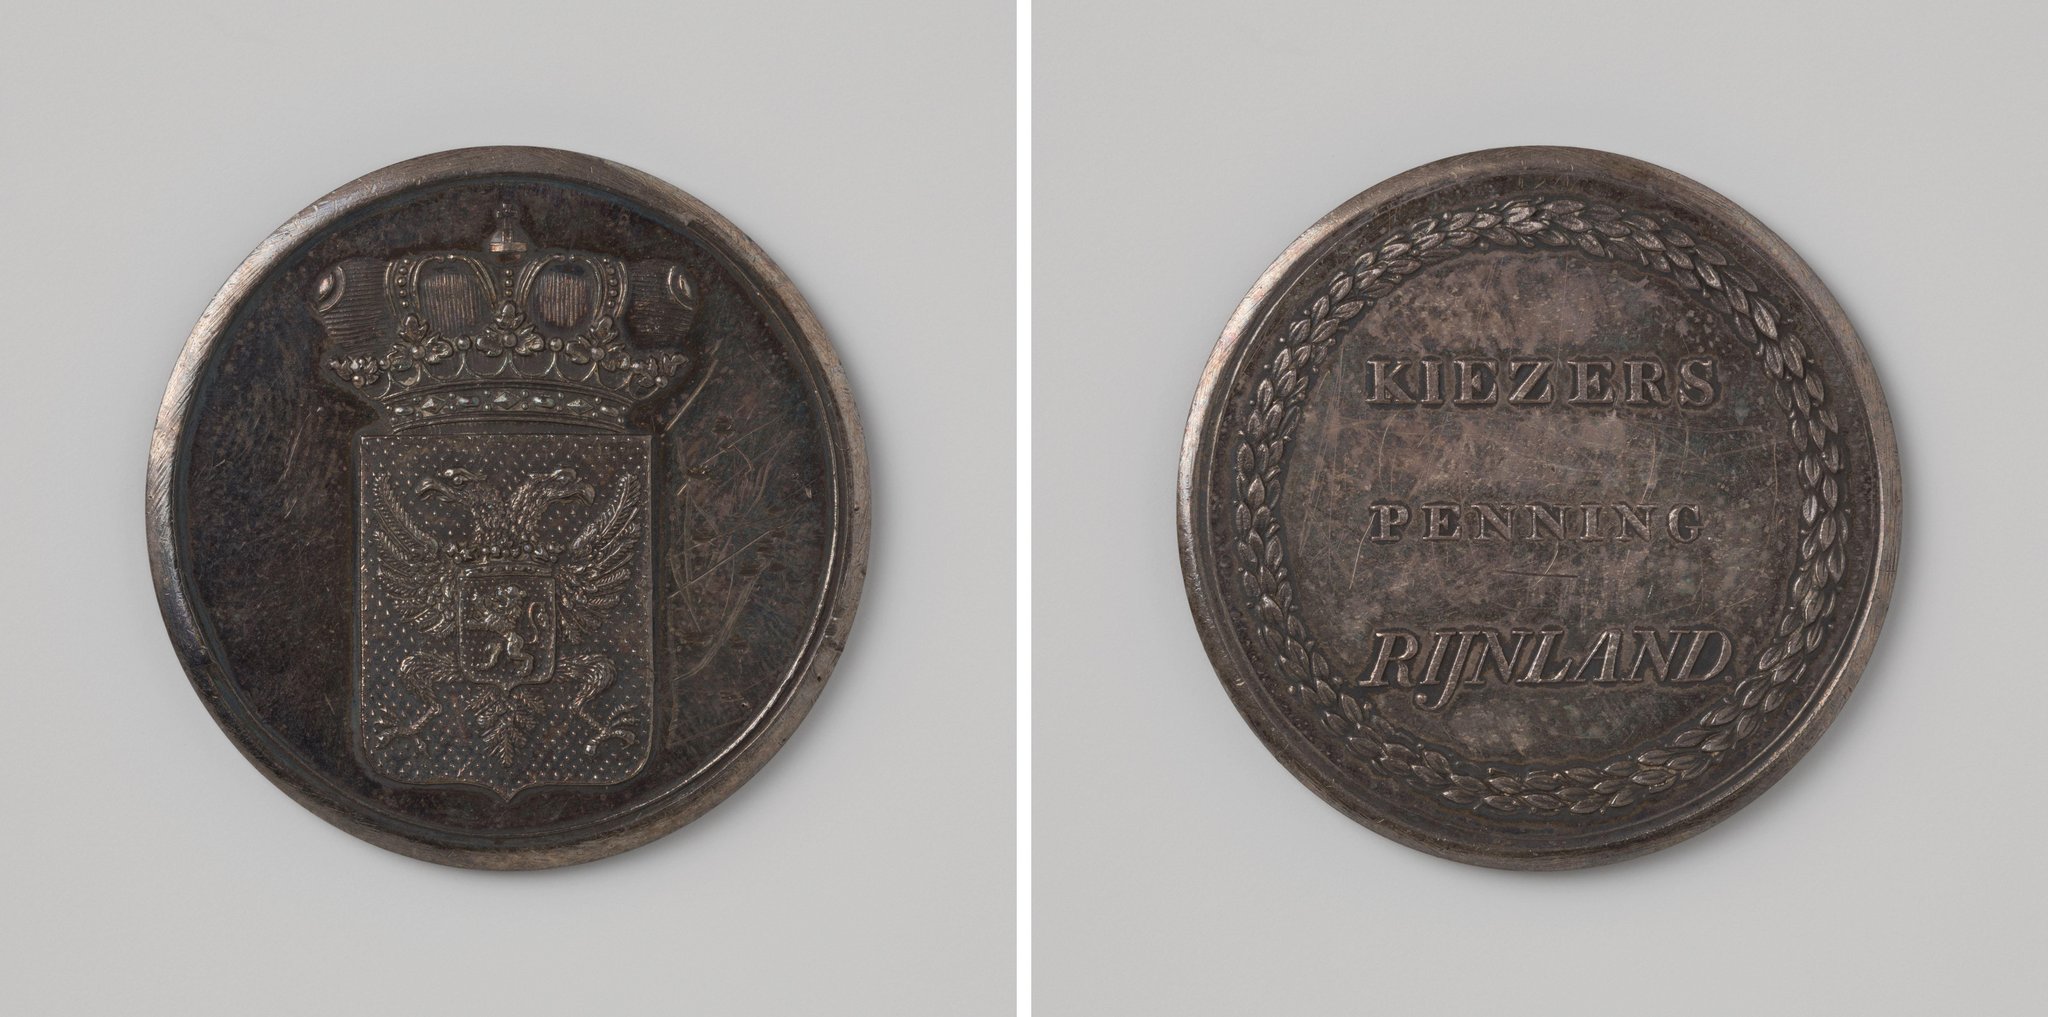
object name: kiezerspenning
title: Verkiezing van de hoofd-ingelanden van het hoogheemraadschap Rijnland, penning uitgedeeld aan elke verschenen kiezer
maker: Anonymous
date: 1818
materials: silver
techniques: striking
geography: netherlands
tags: hoogheemraadschap van rijnland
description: Zilveren penning. Voorzijde: gekroond wapenschild. Keerzijde: opschrift binnen lauwerkrans